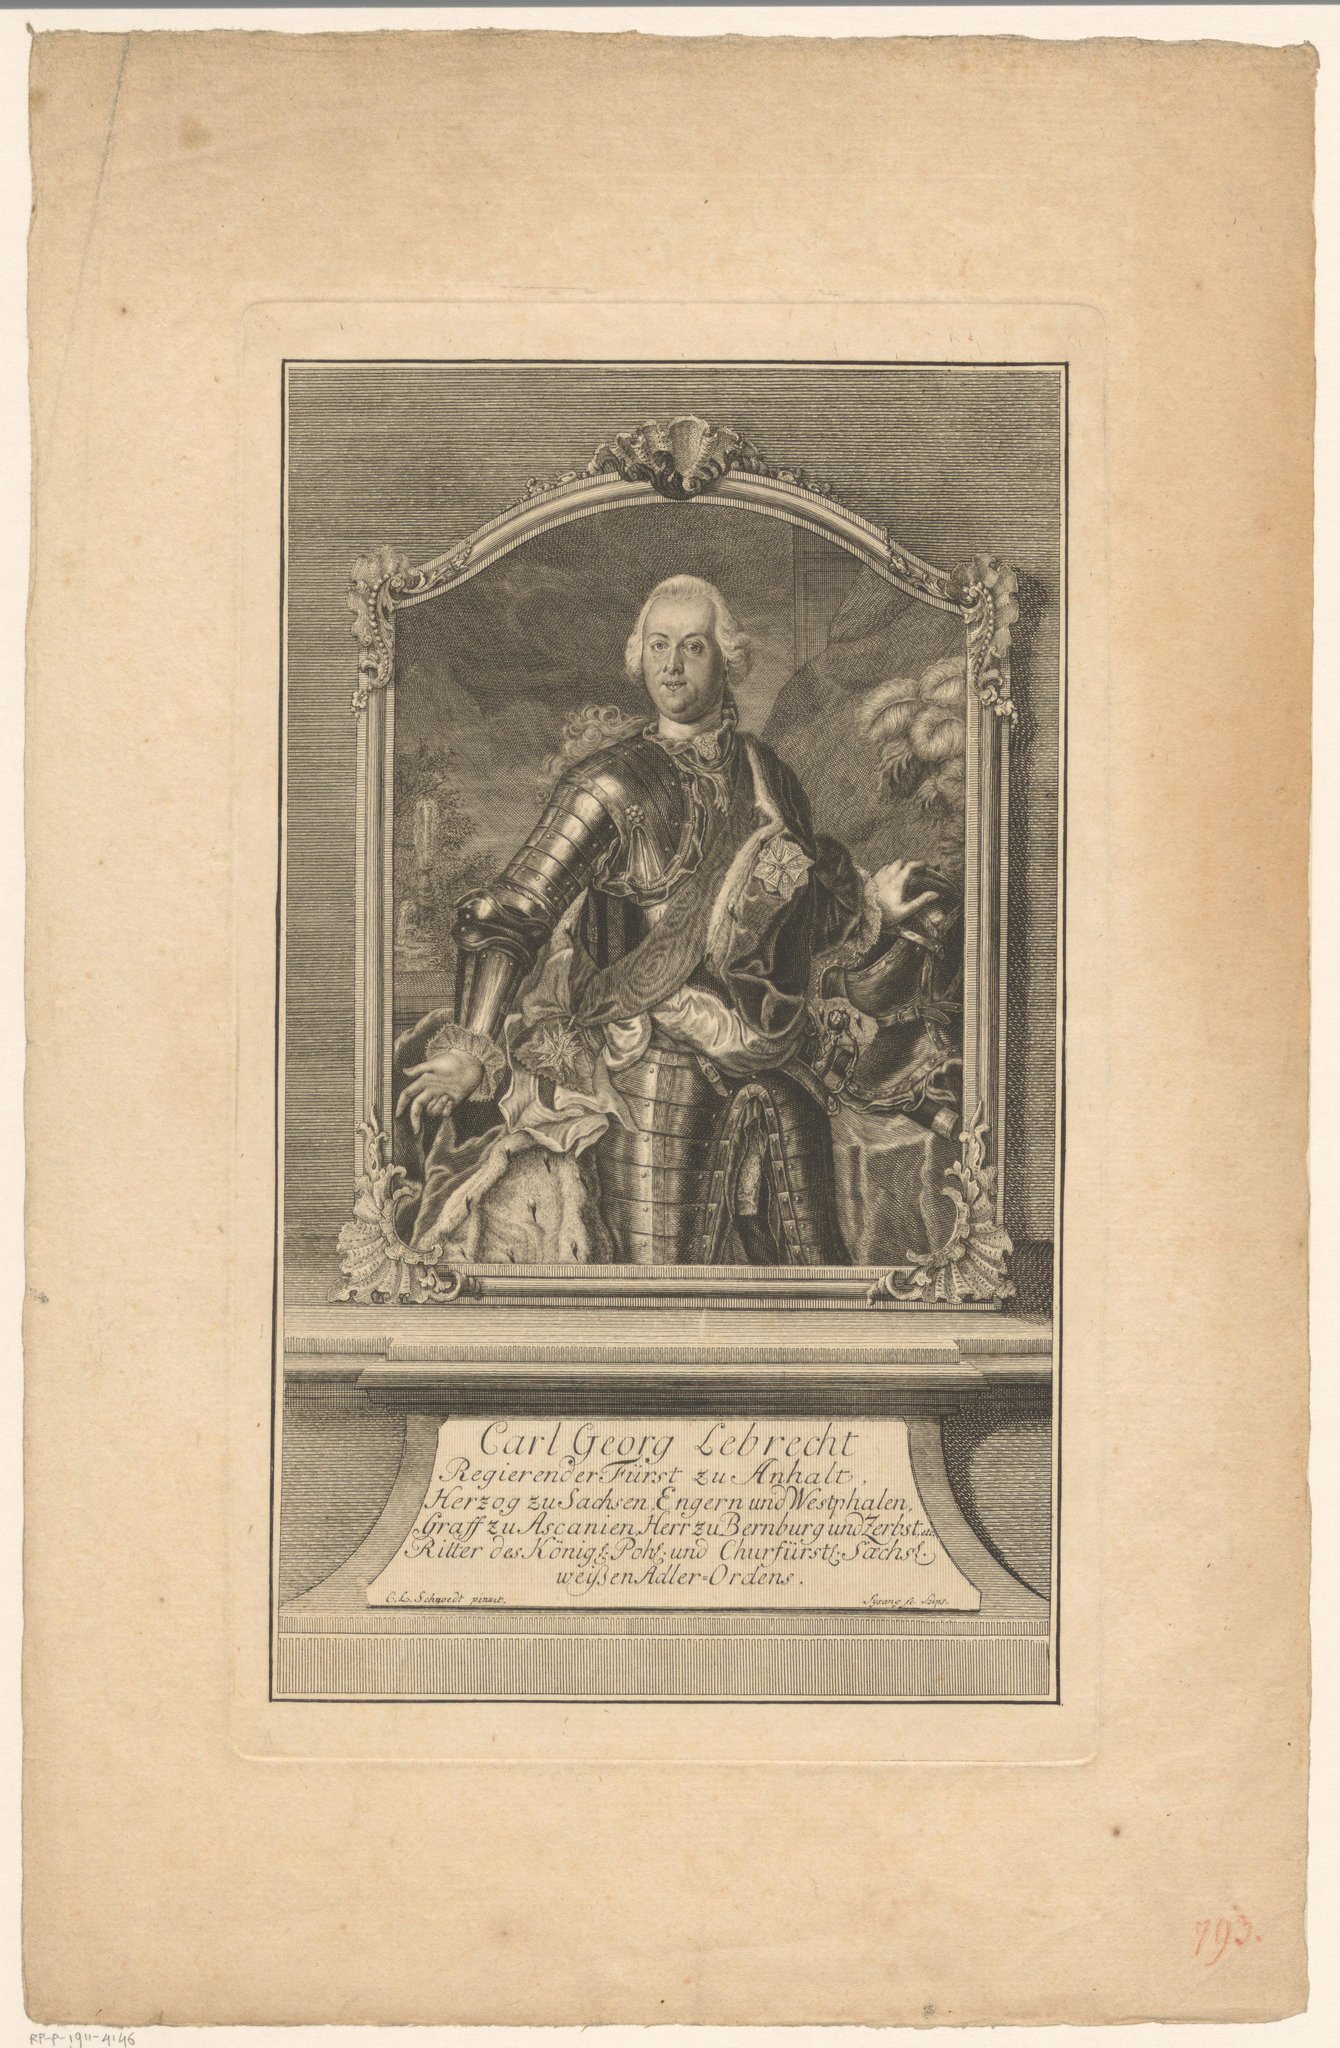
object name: print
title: Portret van Karl Georg Lebrecht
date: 1755-1757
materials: paper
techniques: engraving, etching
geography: leipzig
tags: armour, historical persons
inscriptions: collector's mark: Lugt 2228